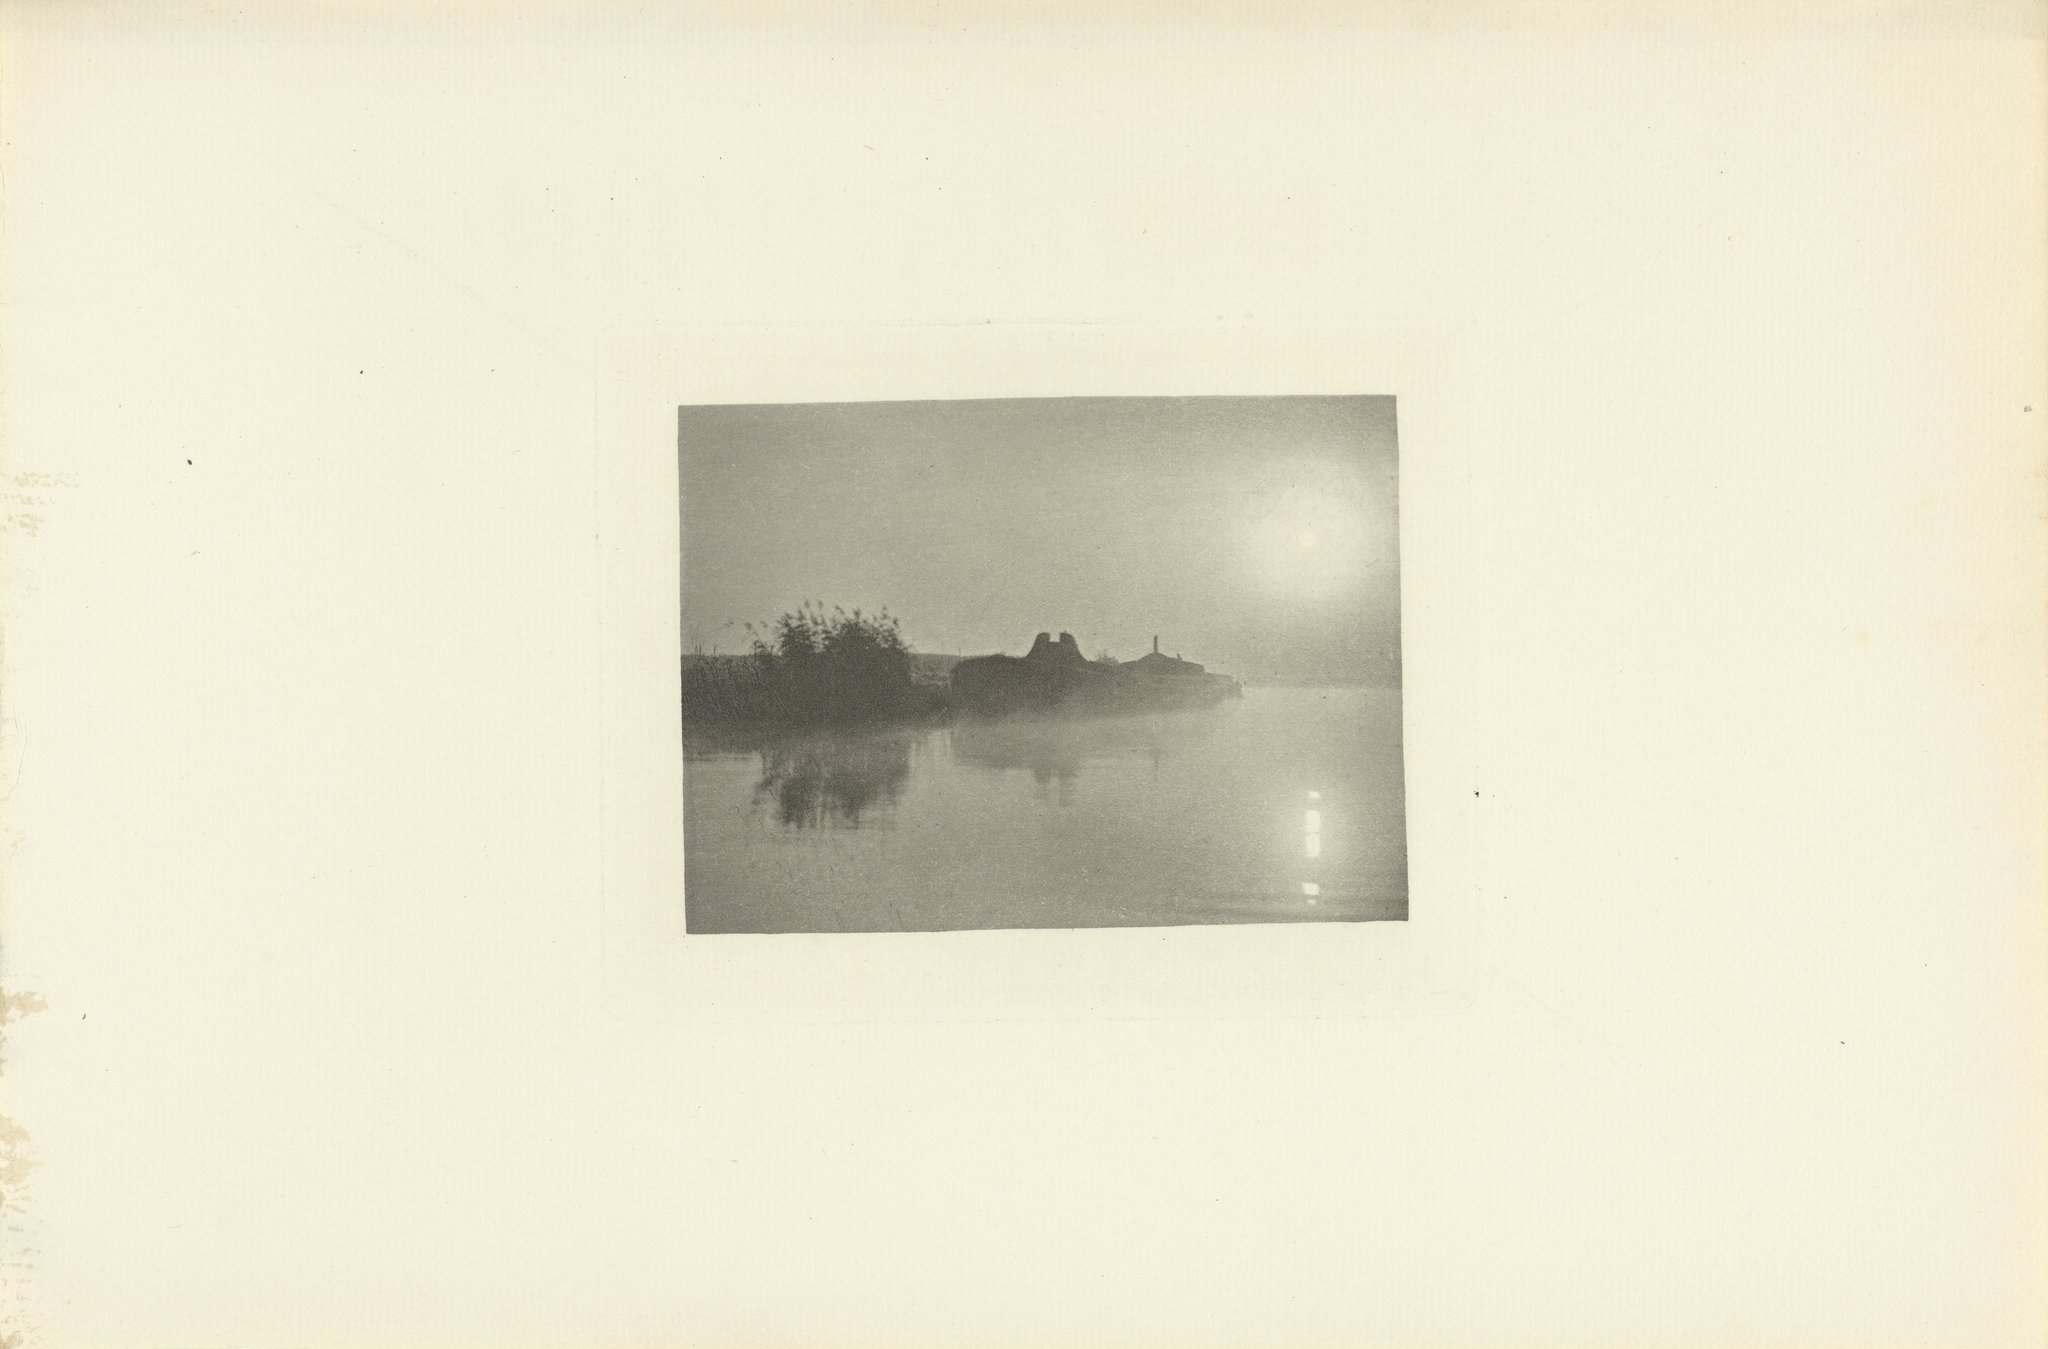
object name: photomechanical print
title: The Waking River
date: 1890-1895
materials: paper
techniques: photoaquatint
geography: great britain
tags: river, morning, mist, fog, great britain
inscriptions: inscription: ‘PLATE X/ THE WAKING RIVER/ To face page 102’